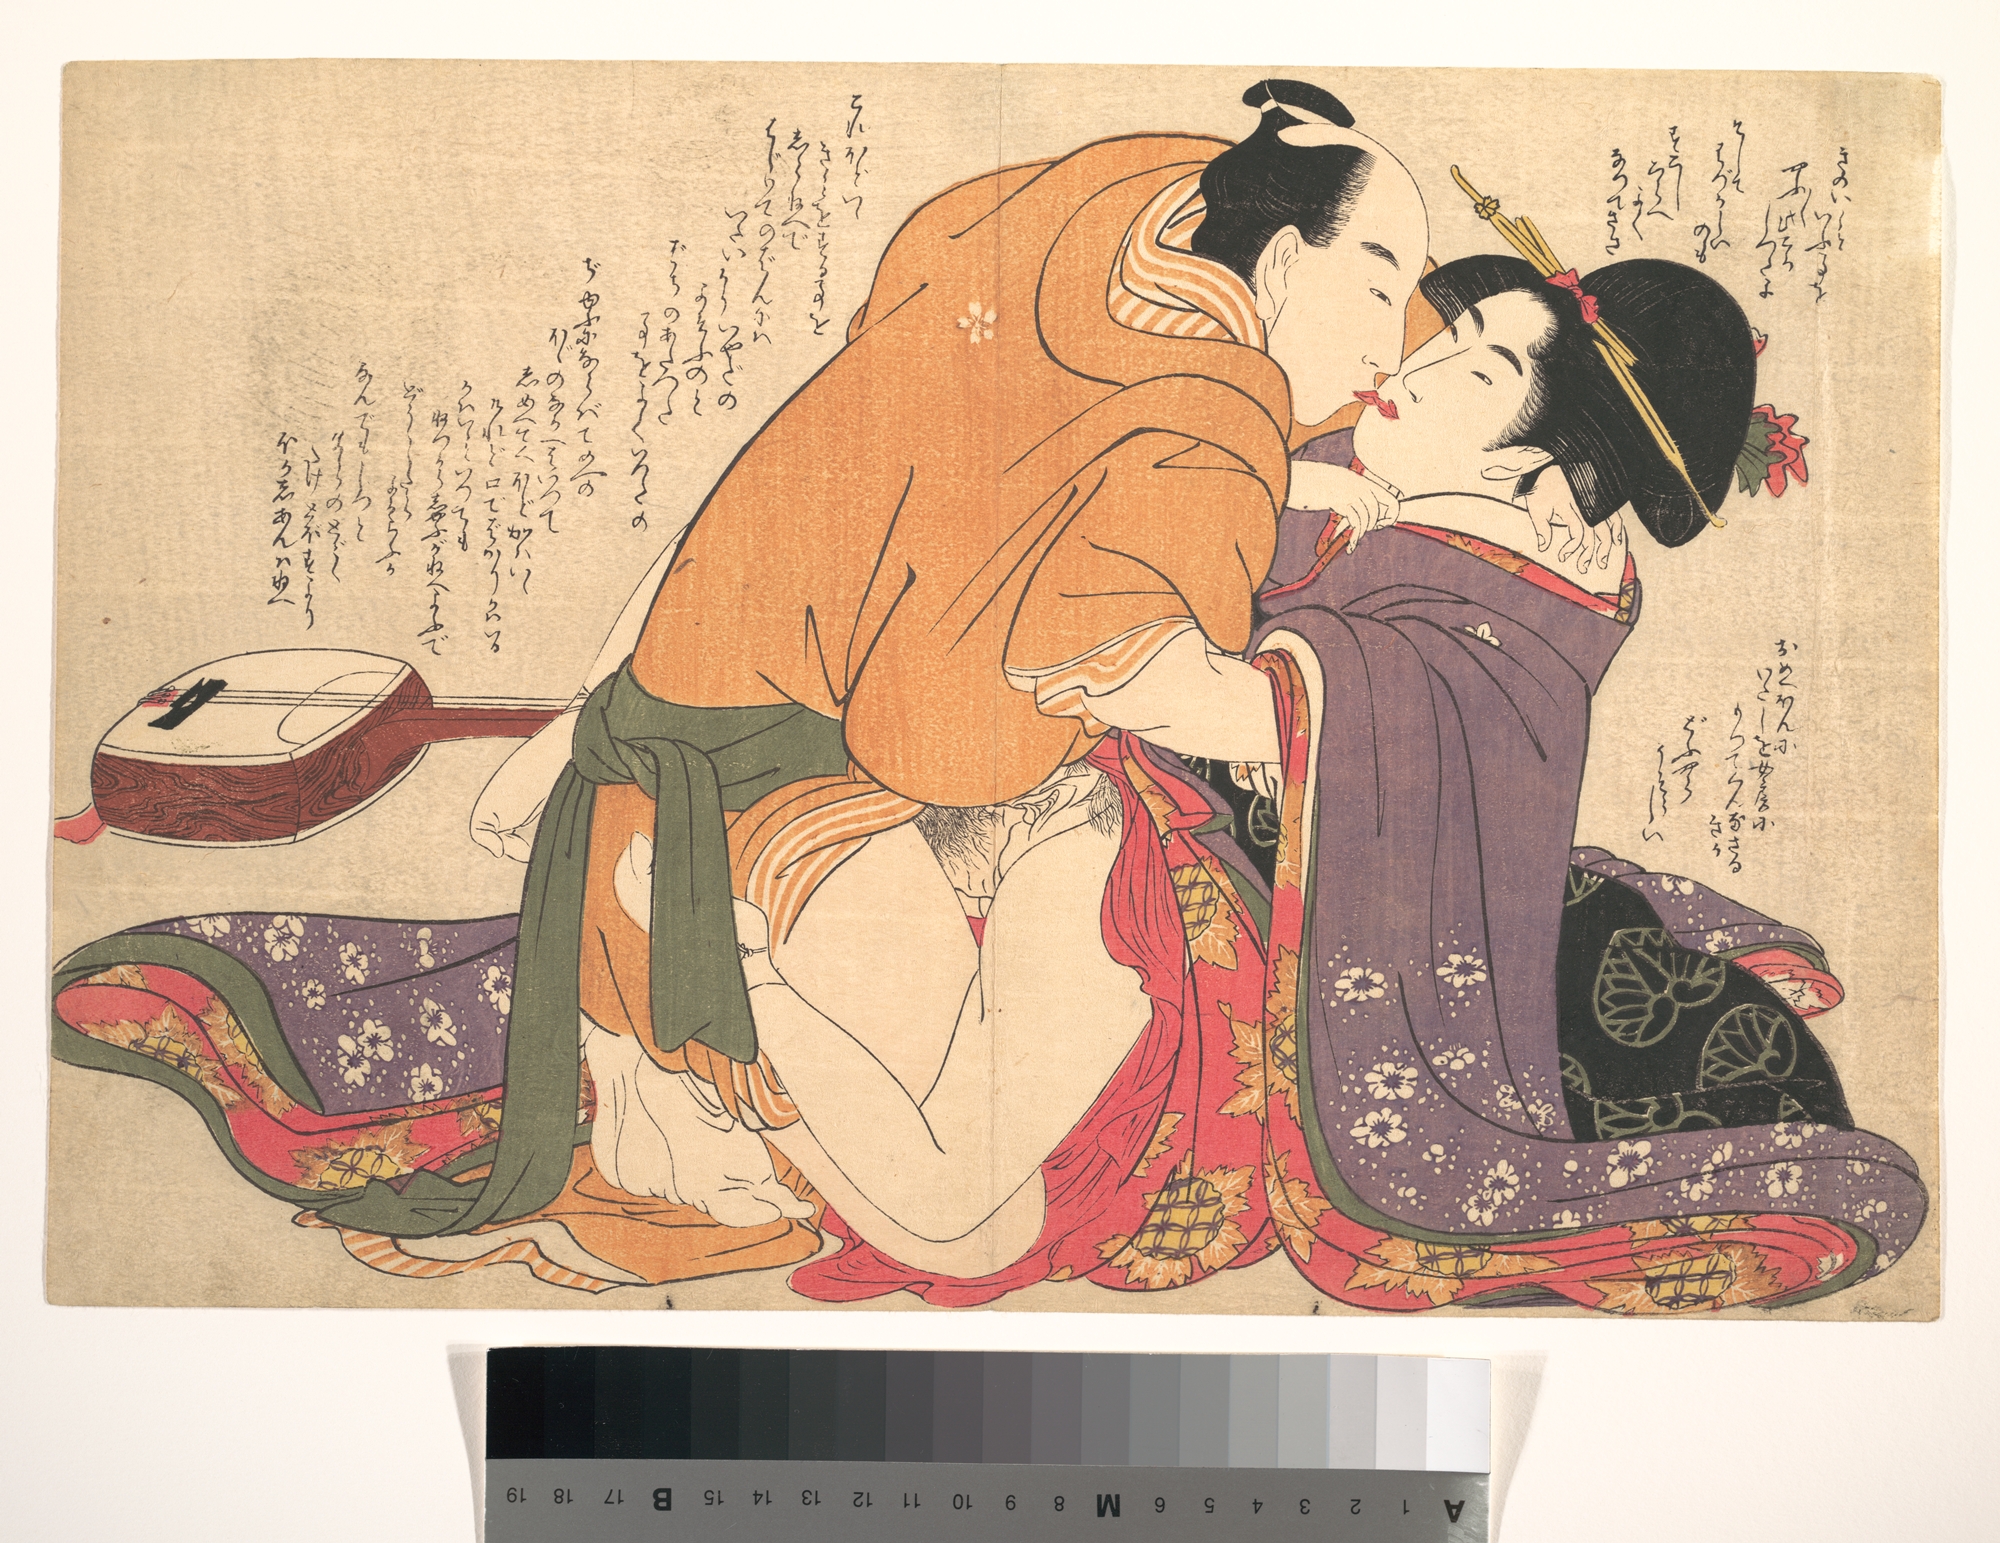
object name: print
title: Erotic Print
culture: japanese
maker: kitagawa utamaro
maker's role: artist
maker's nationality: japanese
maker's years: 1754-1806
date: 1753-1806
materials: ink, paper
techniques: woodblock print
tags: male nudes,female nudes